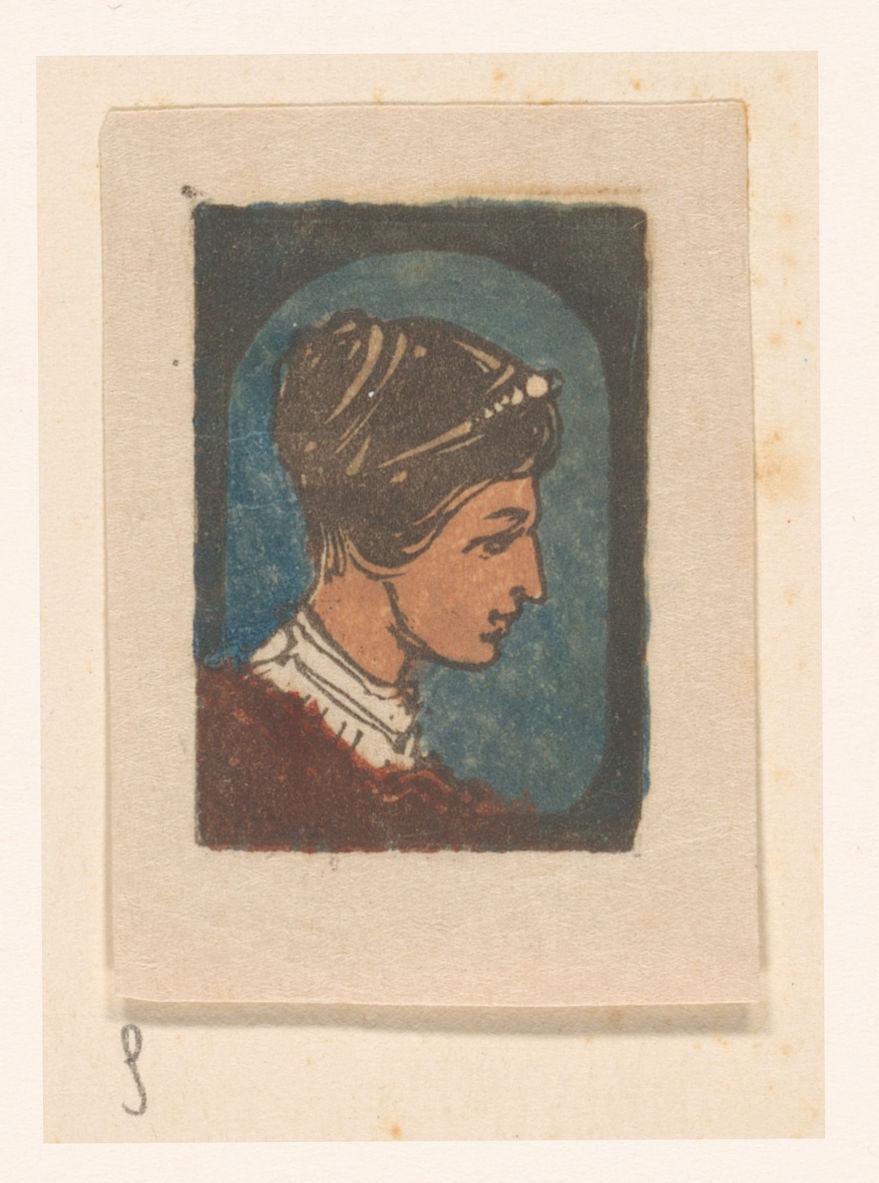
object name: print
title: Hoofd van een vrouw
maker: bernard willem wierink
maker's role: draughtsman, print maker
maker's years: 1856-1939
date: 1866-1939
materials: paper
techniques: relief print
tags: anonymous historical person portrayed - bb - woman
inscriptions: collector's mark: Lugt 2228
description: Deze prent is vermoedelijk een plaatsnede, ook al wordt in de literatuur veelal gesproken over een houtsnede. Voor zover Wierink zijn prenten in hoogdruk zelf nader heeft omschreven, heeft hij altijd de term 'plaatsnede' gebruikt.